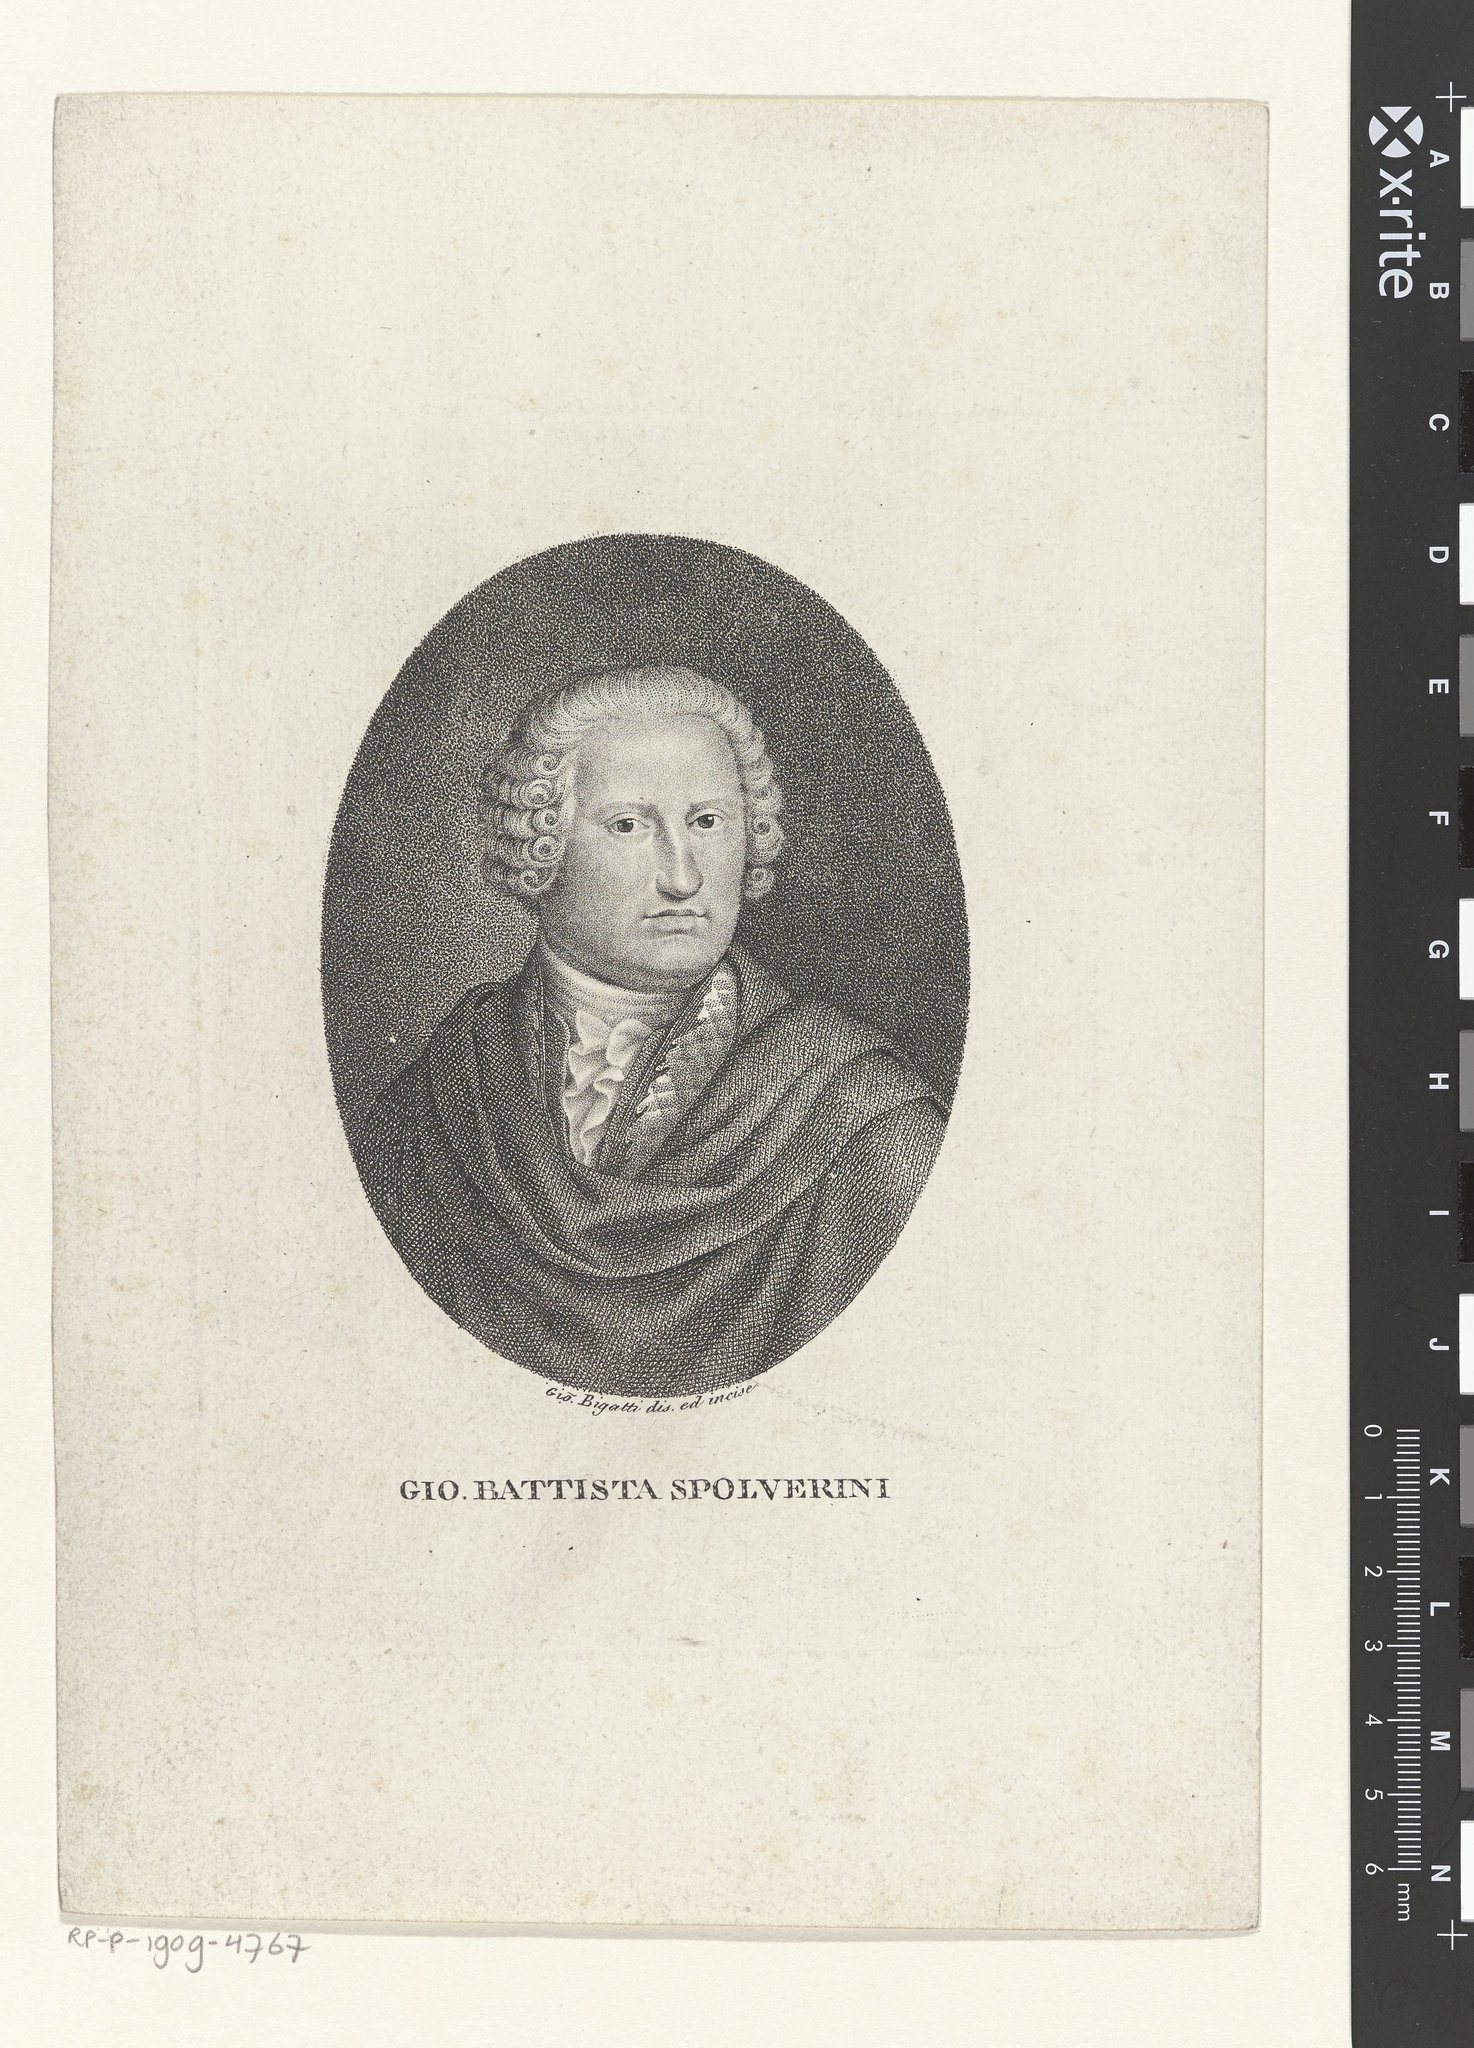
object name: print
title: Portret van Giovanni Battista Spolverini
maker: giovanni bigatti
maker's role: print maker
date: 1800-1900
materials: paper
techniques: stippled etching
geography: italy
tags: historical persons, portrait of a writer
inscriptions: collector's mark: Lugt 2228